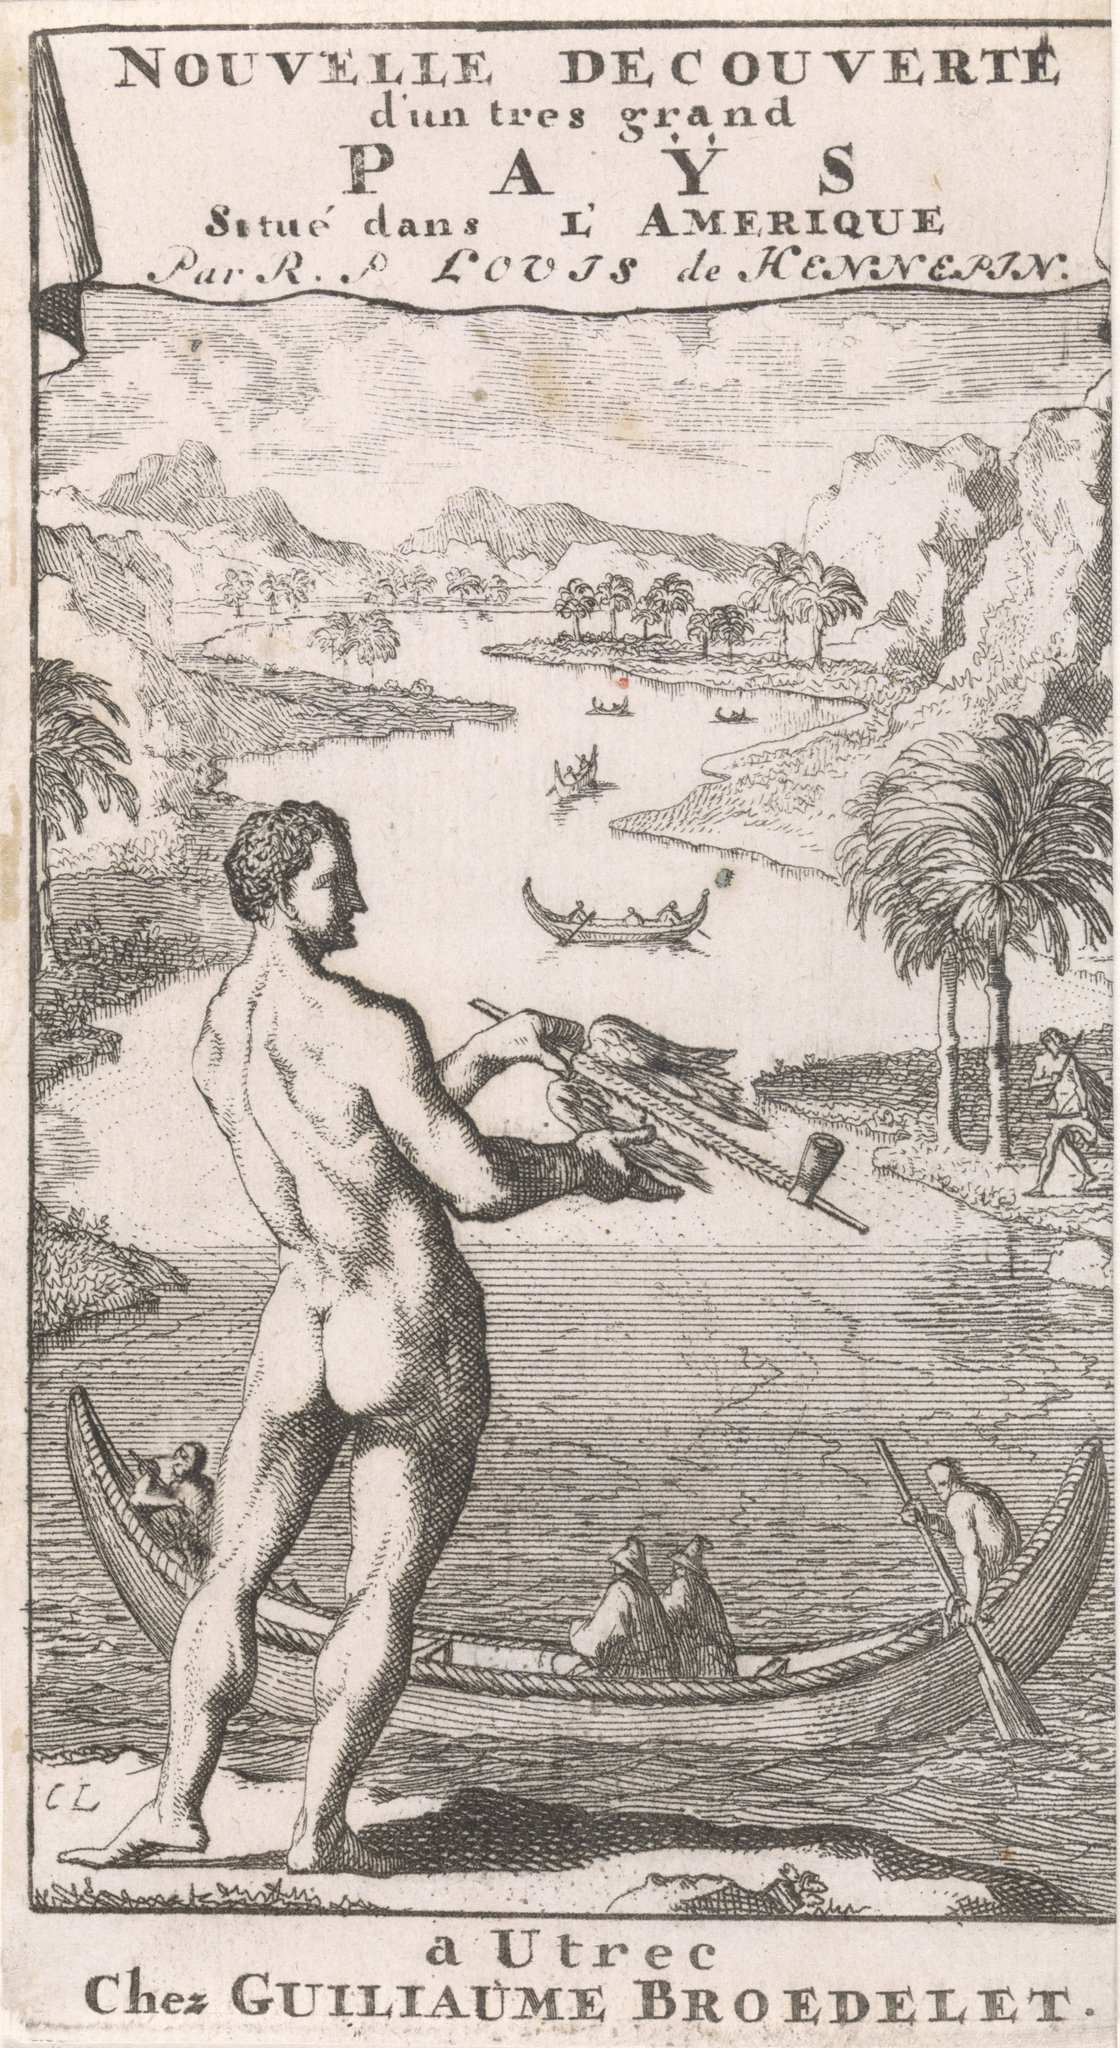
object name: titelblad, titelpagina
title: Noord-Amerikaans rivierlandschap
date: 1697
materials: paper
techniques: etching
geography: amsterdam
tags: ritual practices ~ american indian religions, pipe ~ tobacco, indigenous peoples of north america, landscapes in the non-temperate zone, exotic landscapes, rowing-boat, canoe, etc.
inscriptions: collector's mark: Lugt 2228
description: Titelpagina voor: Hennepin, Louis. Nouvelle decouverte d'un tres grand pays situé dans l'Amerique, entre le Nouveau Mexique, et la mer Glaciale. Utrecht: Willem Broedelet, 1697.